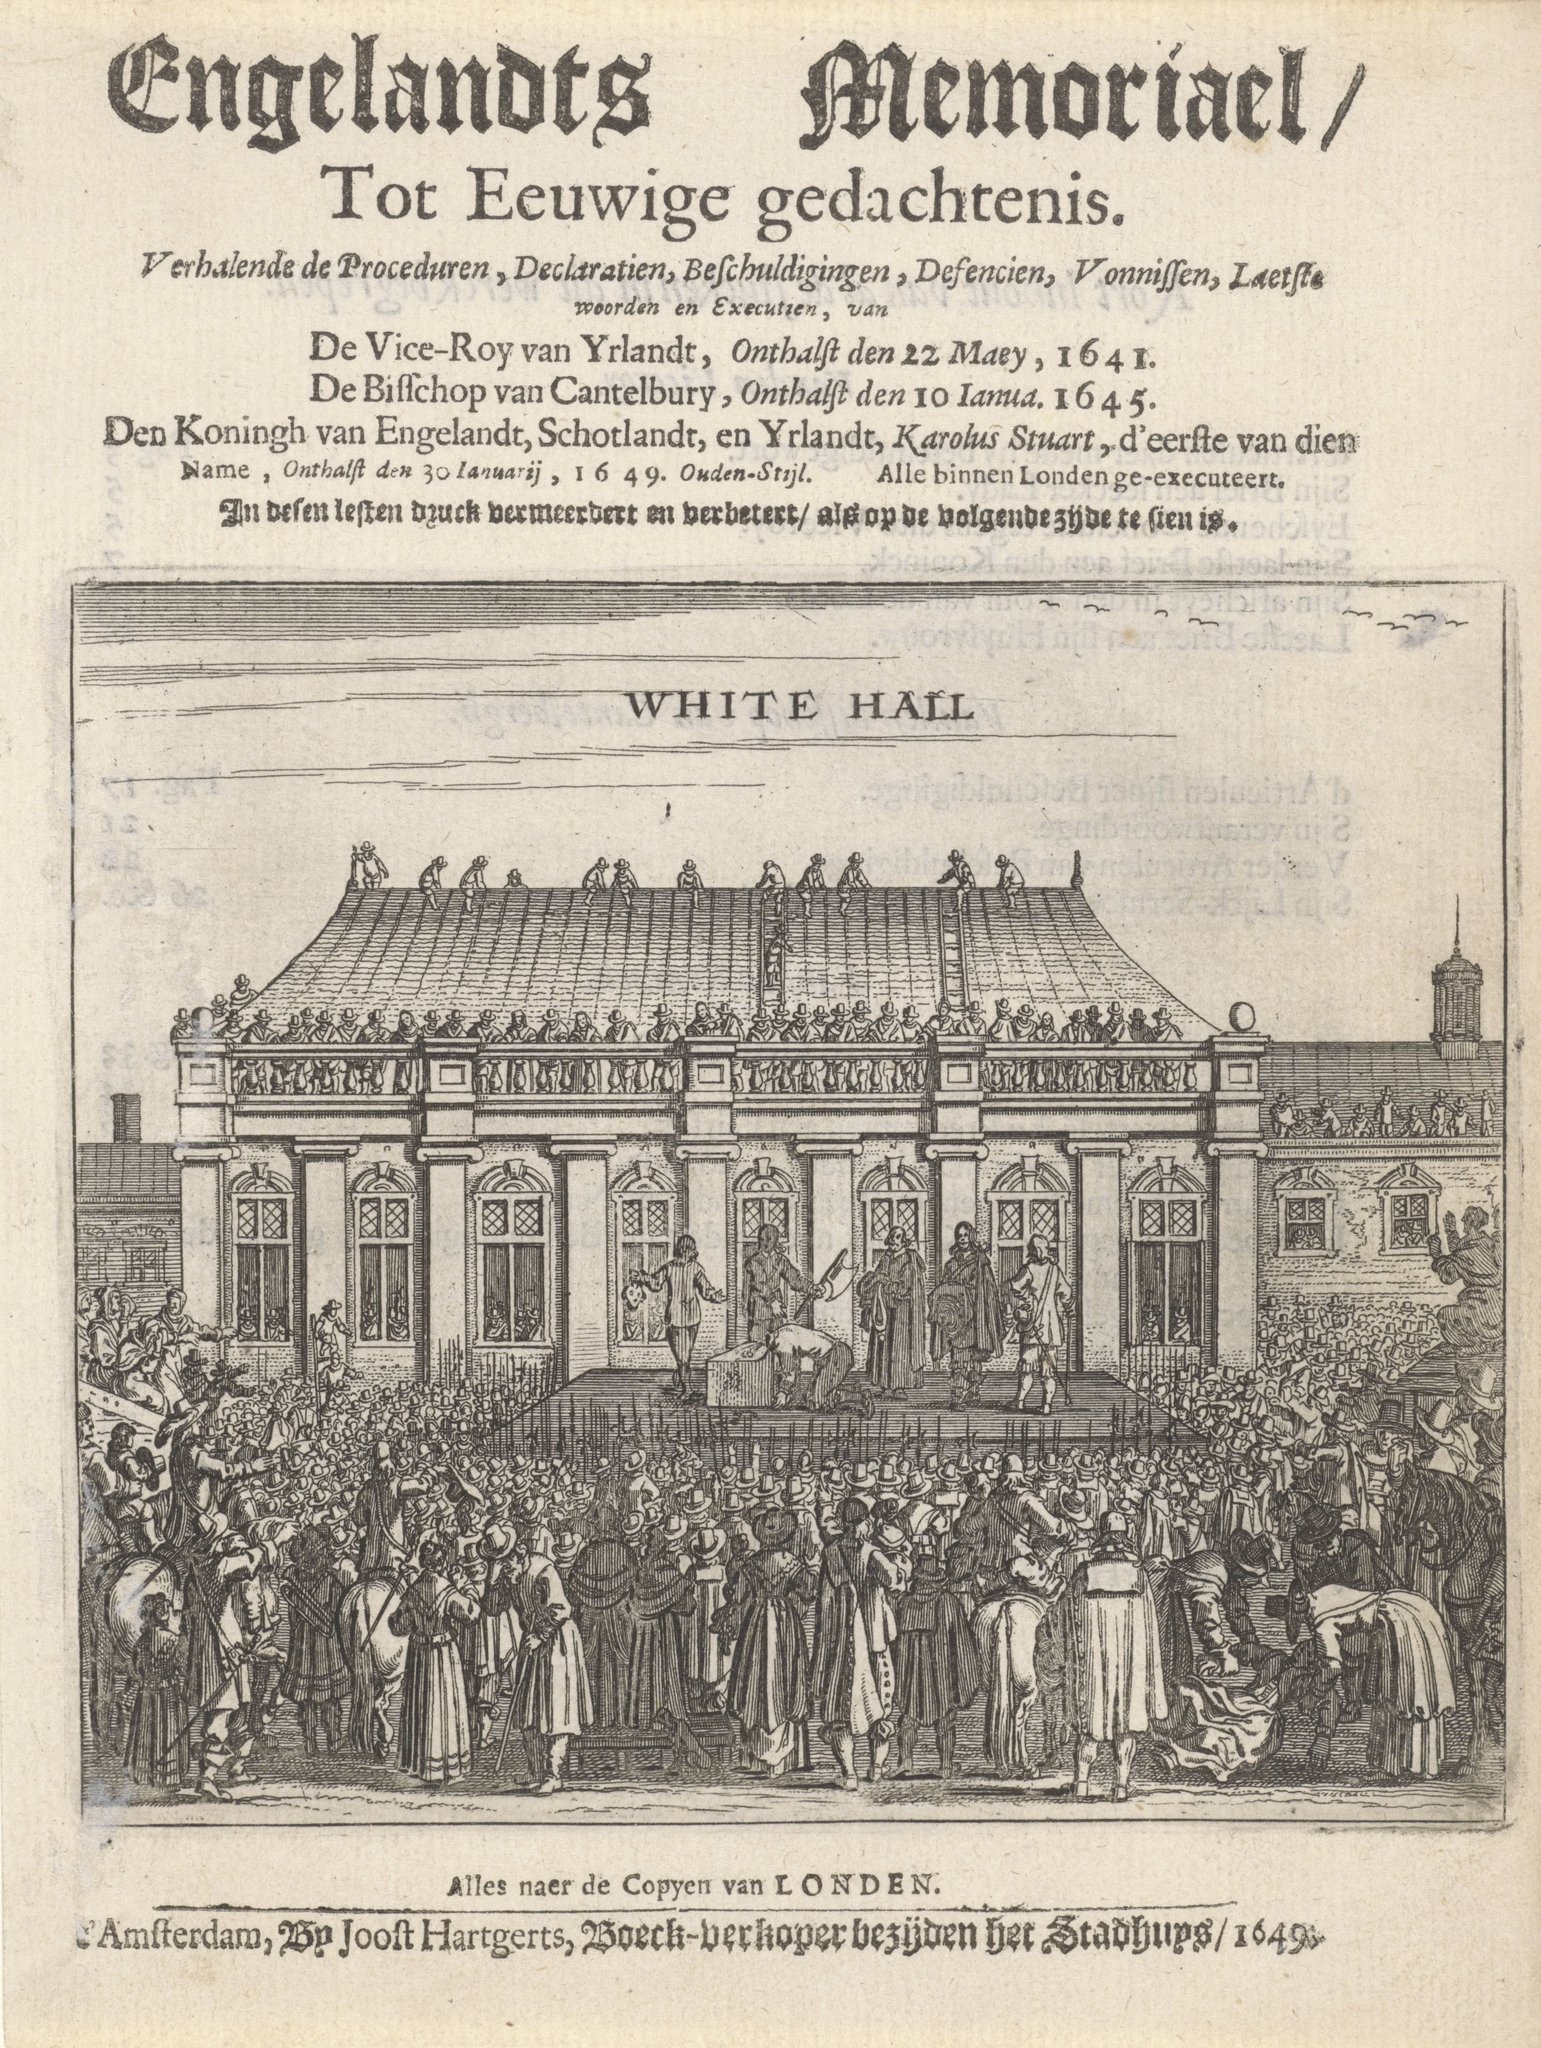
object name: print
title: Terechtstelling voor Whitehall te Londen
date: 1649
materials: paper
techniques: etching, letterpress printing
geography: amsterdam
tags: violent death by beheading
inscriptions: collector's mark: Lugt 2760, collector's mark: Lugt 2166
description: Titelpagina voor: Engelandts memoriael, tot eeuwighe gedachtenis. Amsterdam: Joost Hartgers, 1649.